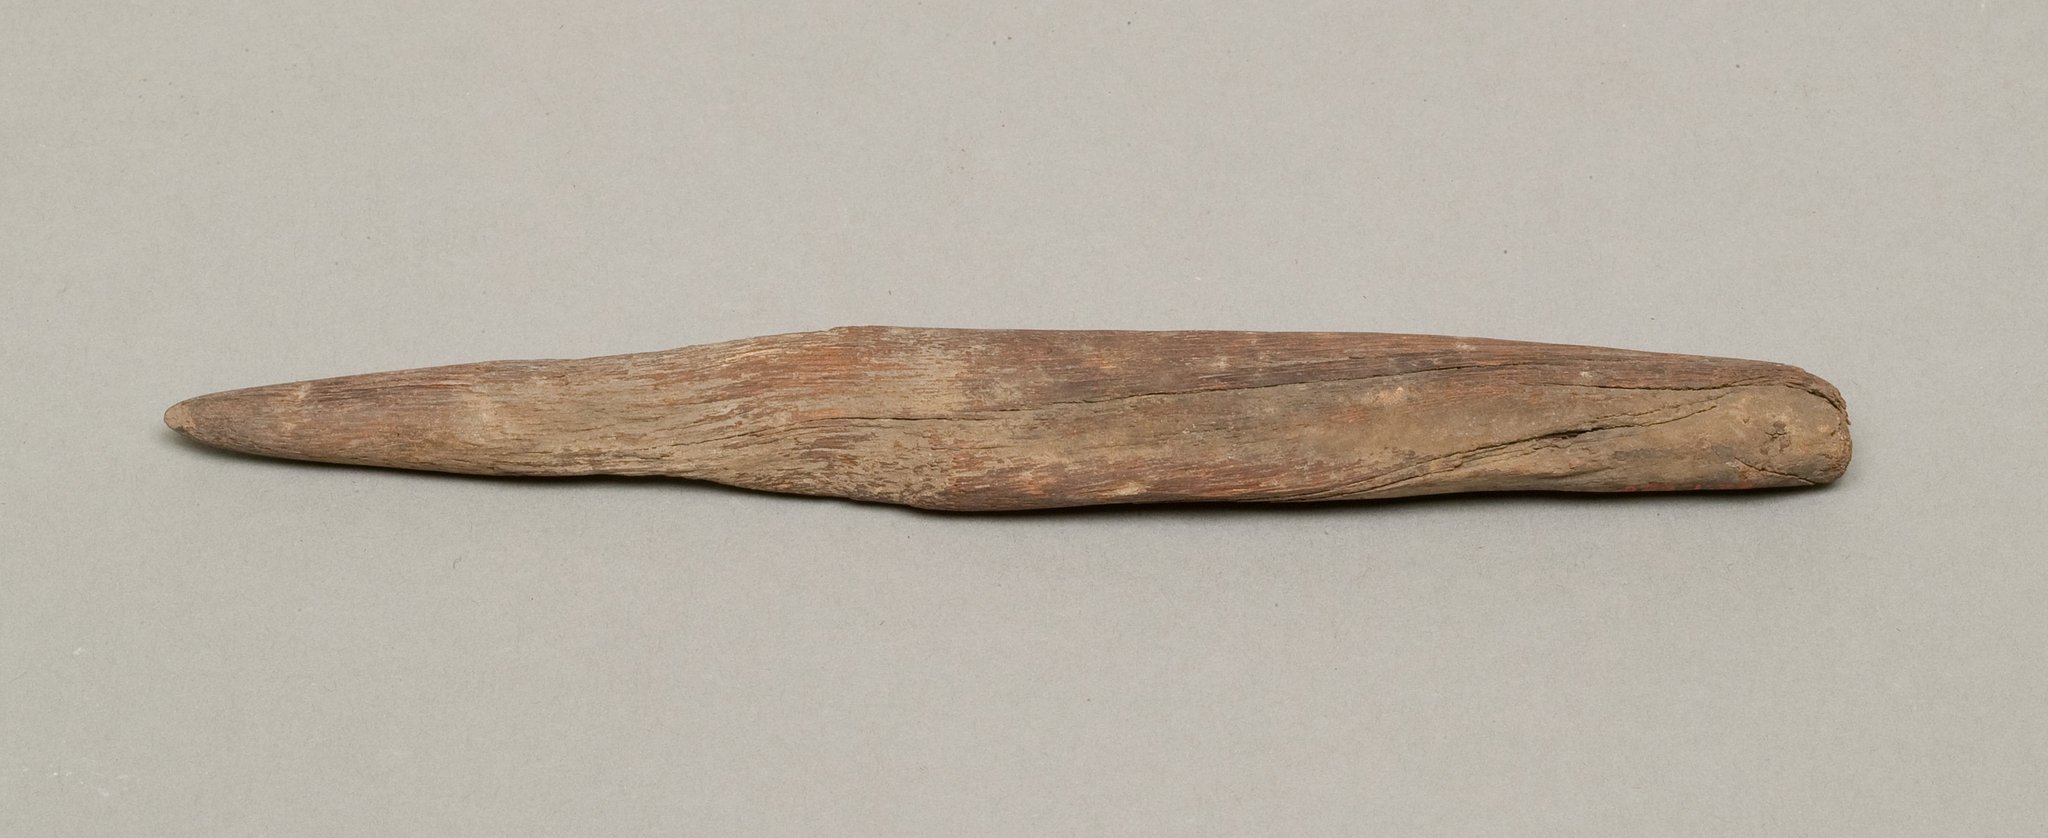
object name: pin beater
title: Weaving tool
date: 1295-1070 BCE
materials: wood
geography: egypt